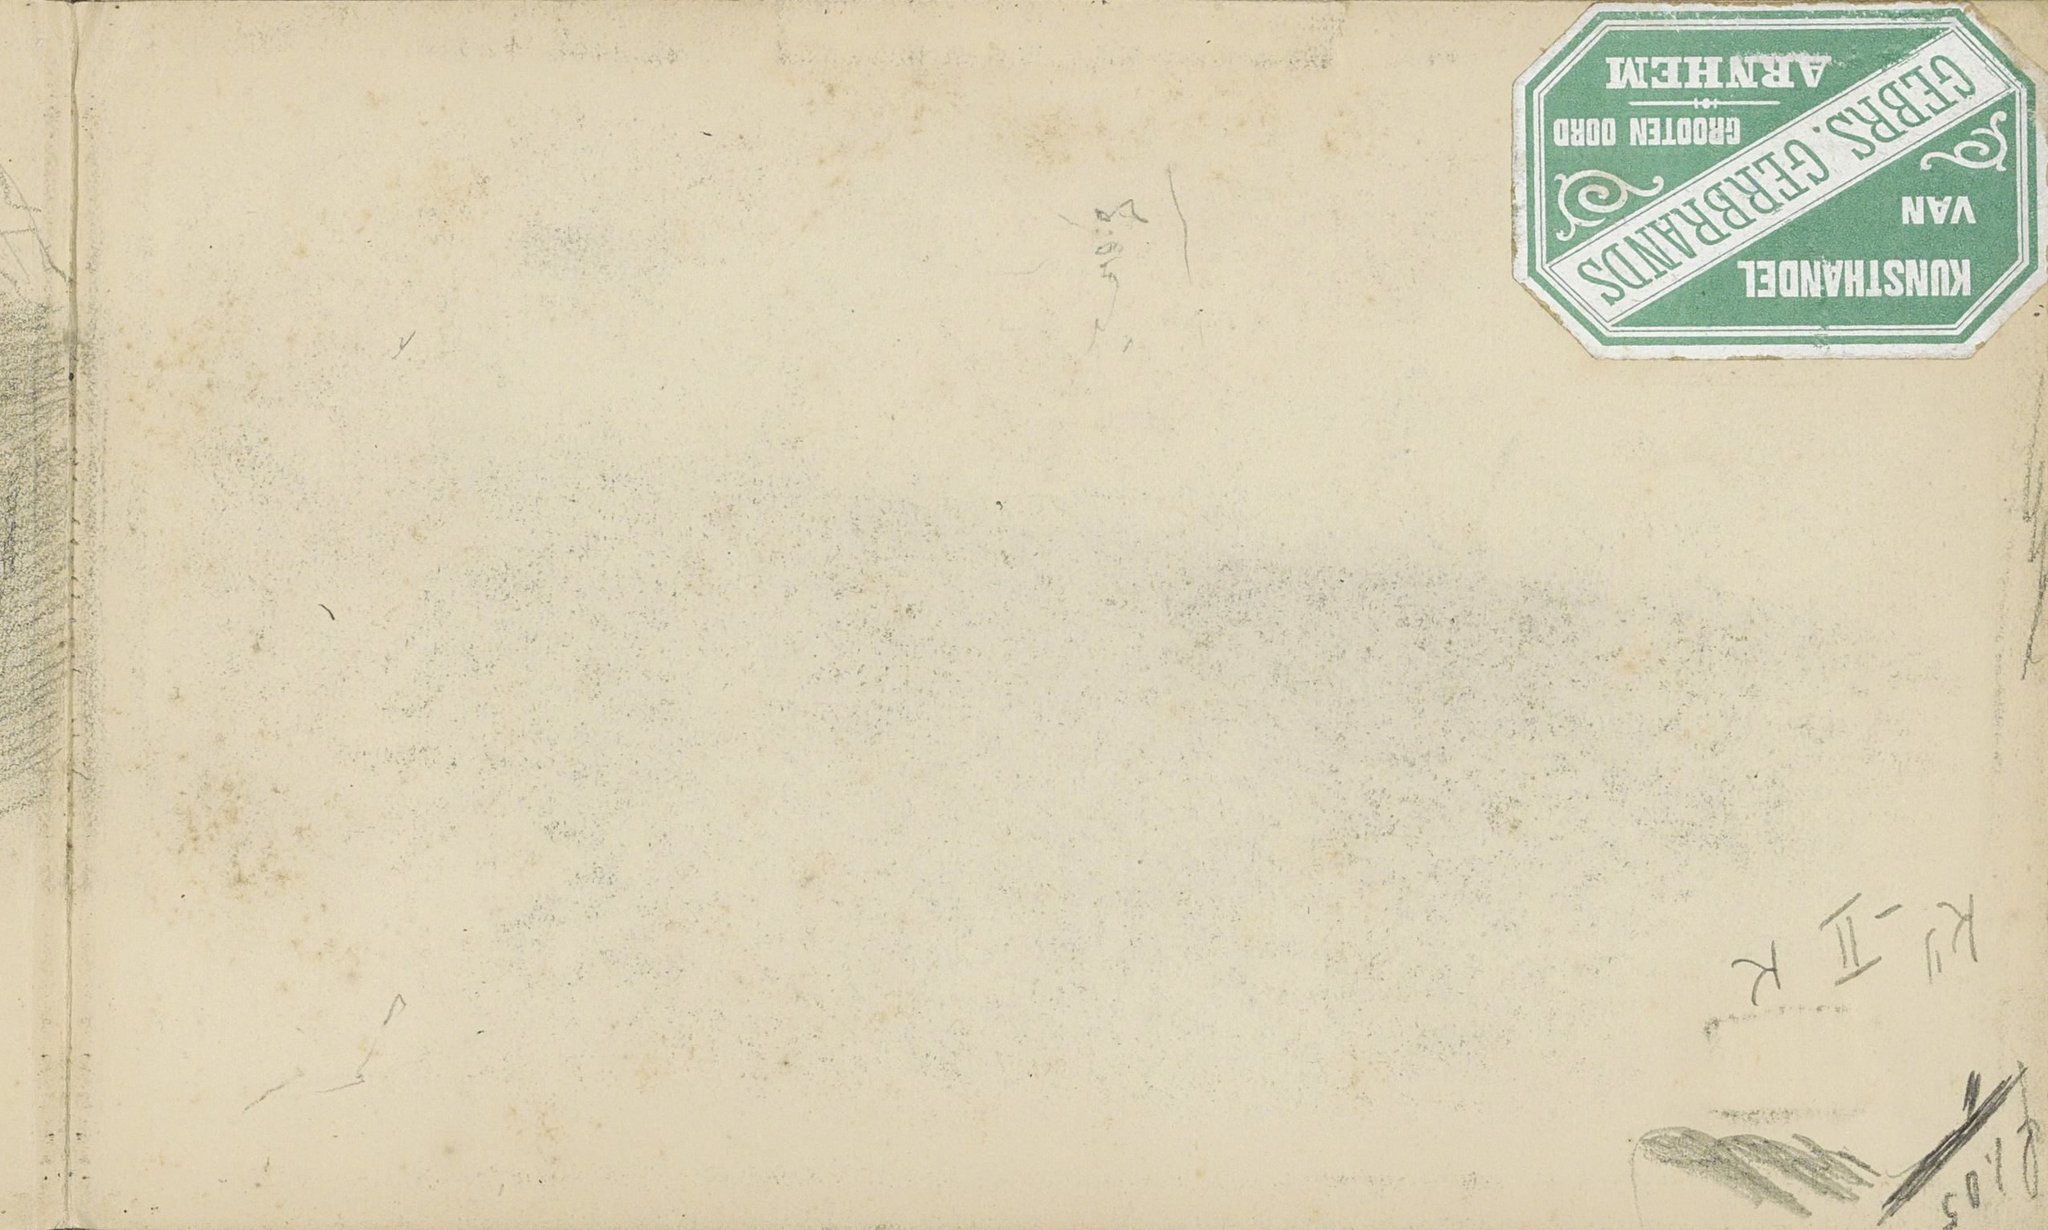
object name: endleaf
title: Studie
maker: anna catharina maria van eeghen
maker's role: draughtsman, print maker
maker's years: 1878-1924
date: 1888-1901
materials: paper, pencil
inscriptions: annotation: ‘f 1.05’, retailer's mark: ‘KUNSTHANDEL/ VAN/ GEBR. GEBRANDS/ GROOTEN OORD/ ARNHEM’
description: Achterste schutblad uit een schetsboek met 33 bladen.